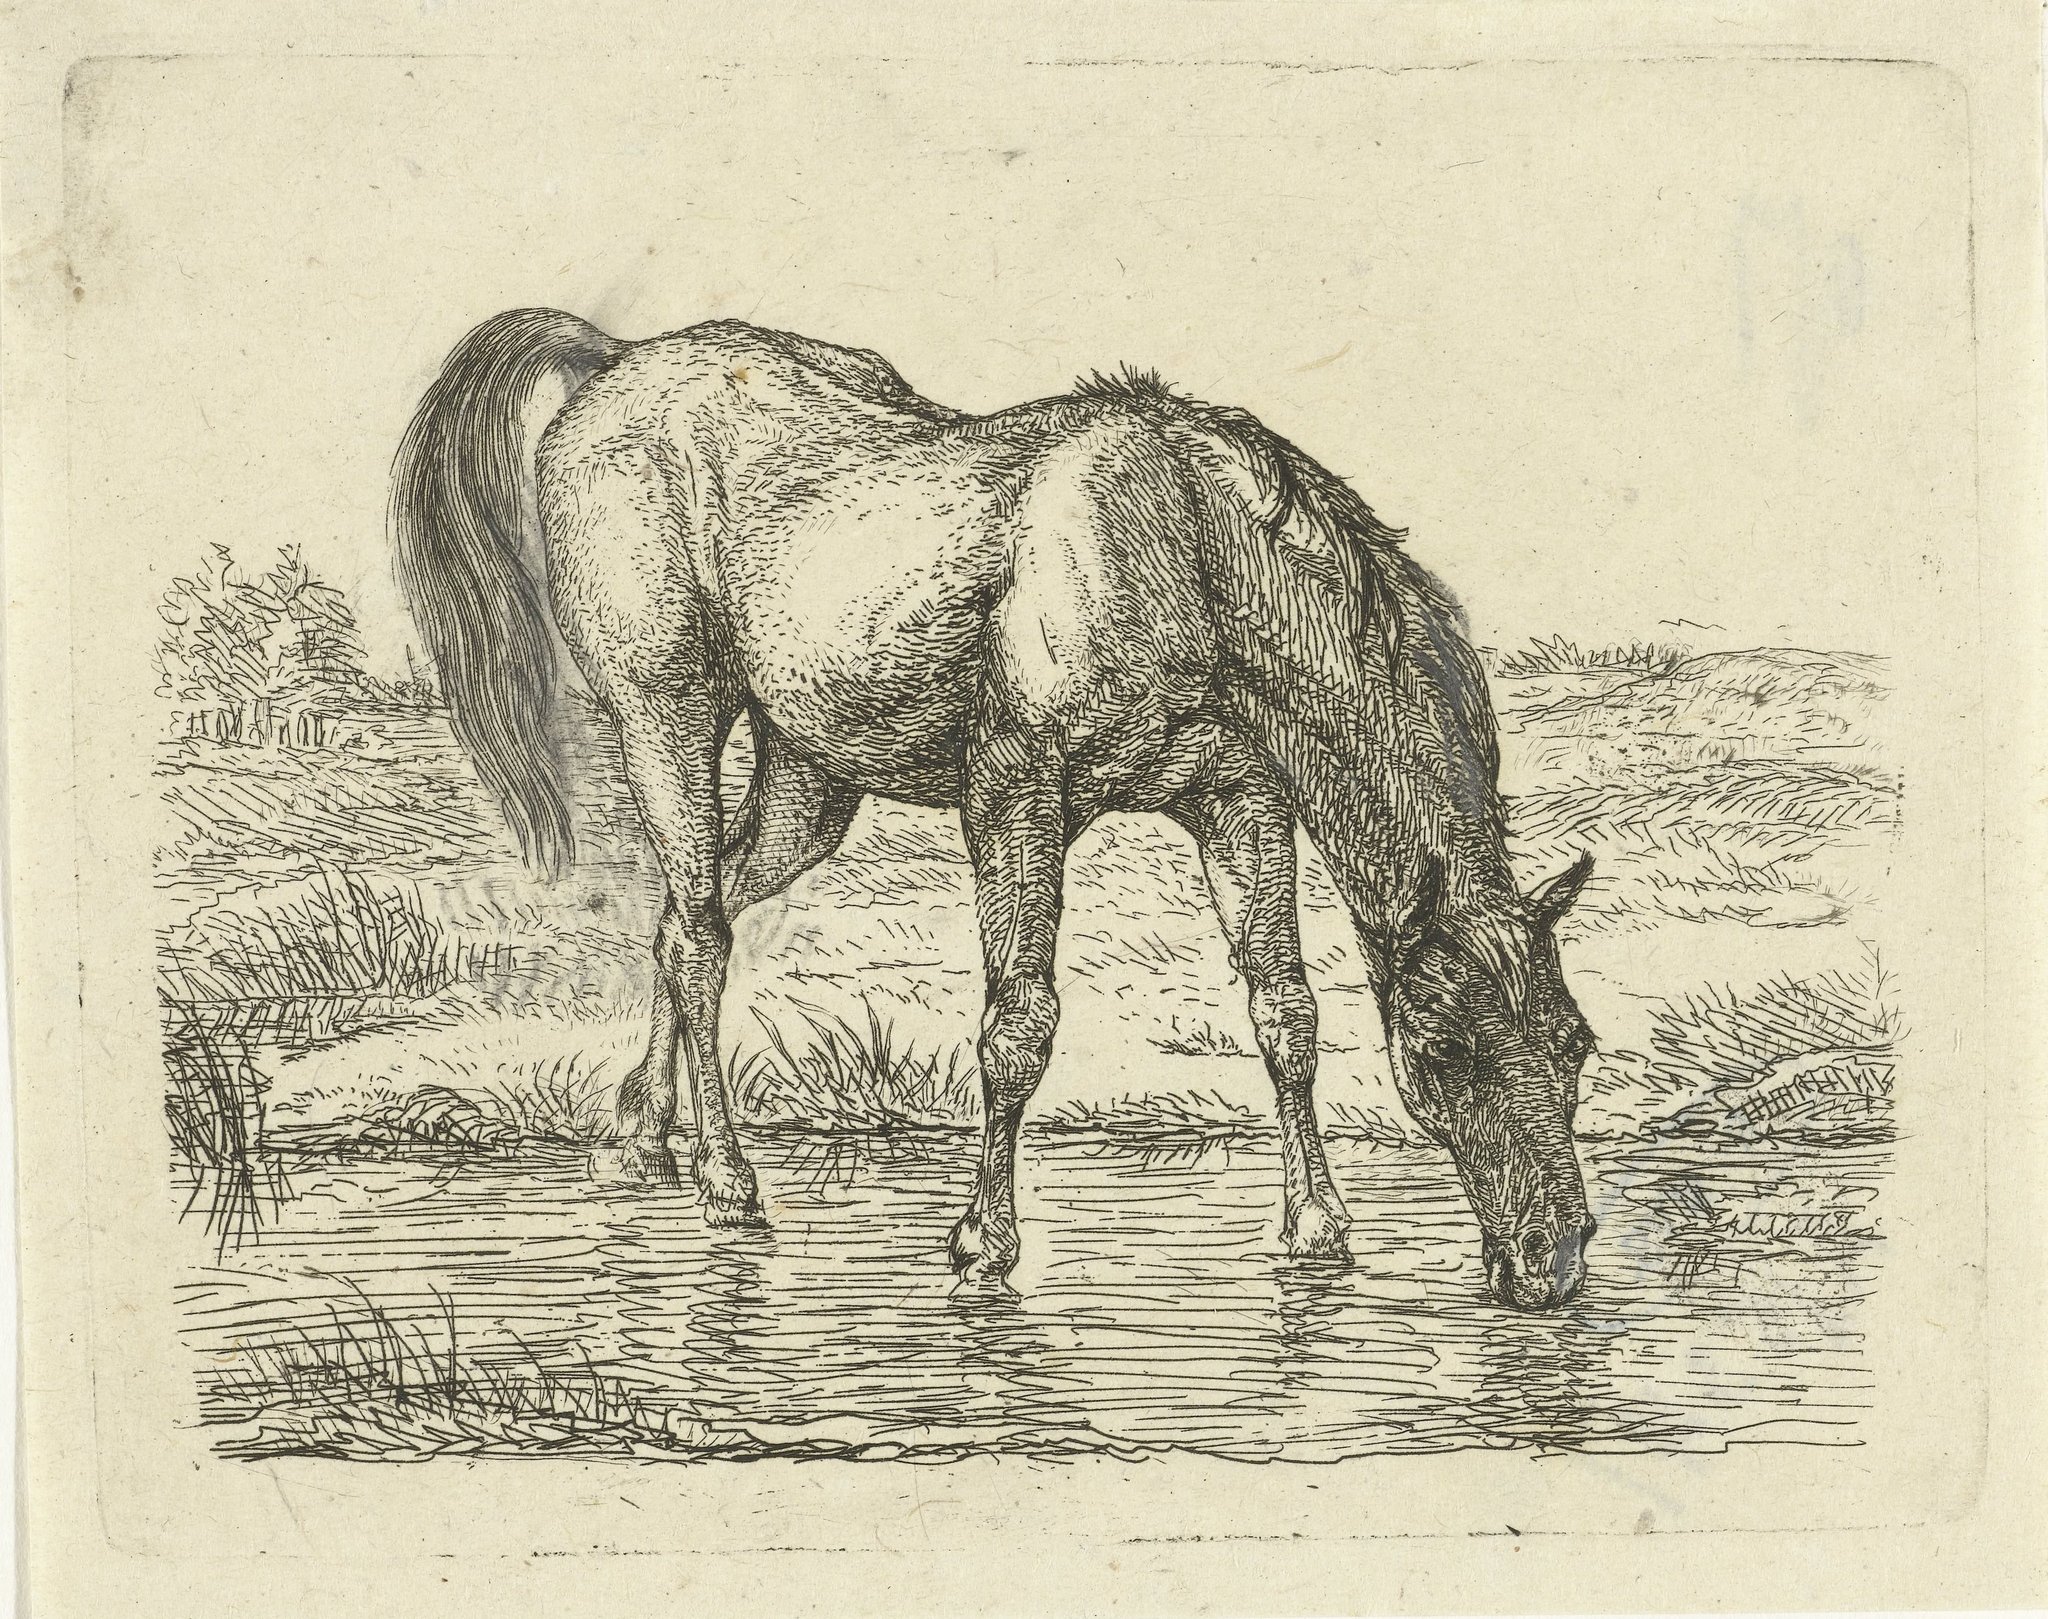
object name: print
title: Drinkend paard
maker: jan dasveldt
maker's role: draughtsman, print maker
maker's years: 1770-1855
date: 1780-1855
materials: chalk, paper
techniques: etching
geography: amsterdam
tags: horses and kindred animals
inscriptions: collector's mark: Lugt 2228